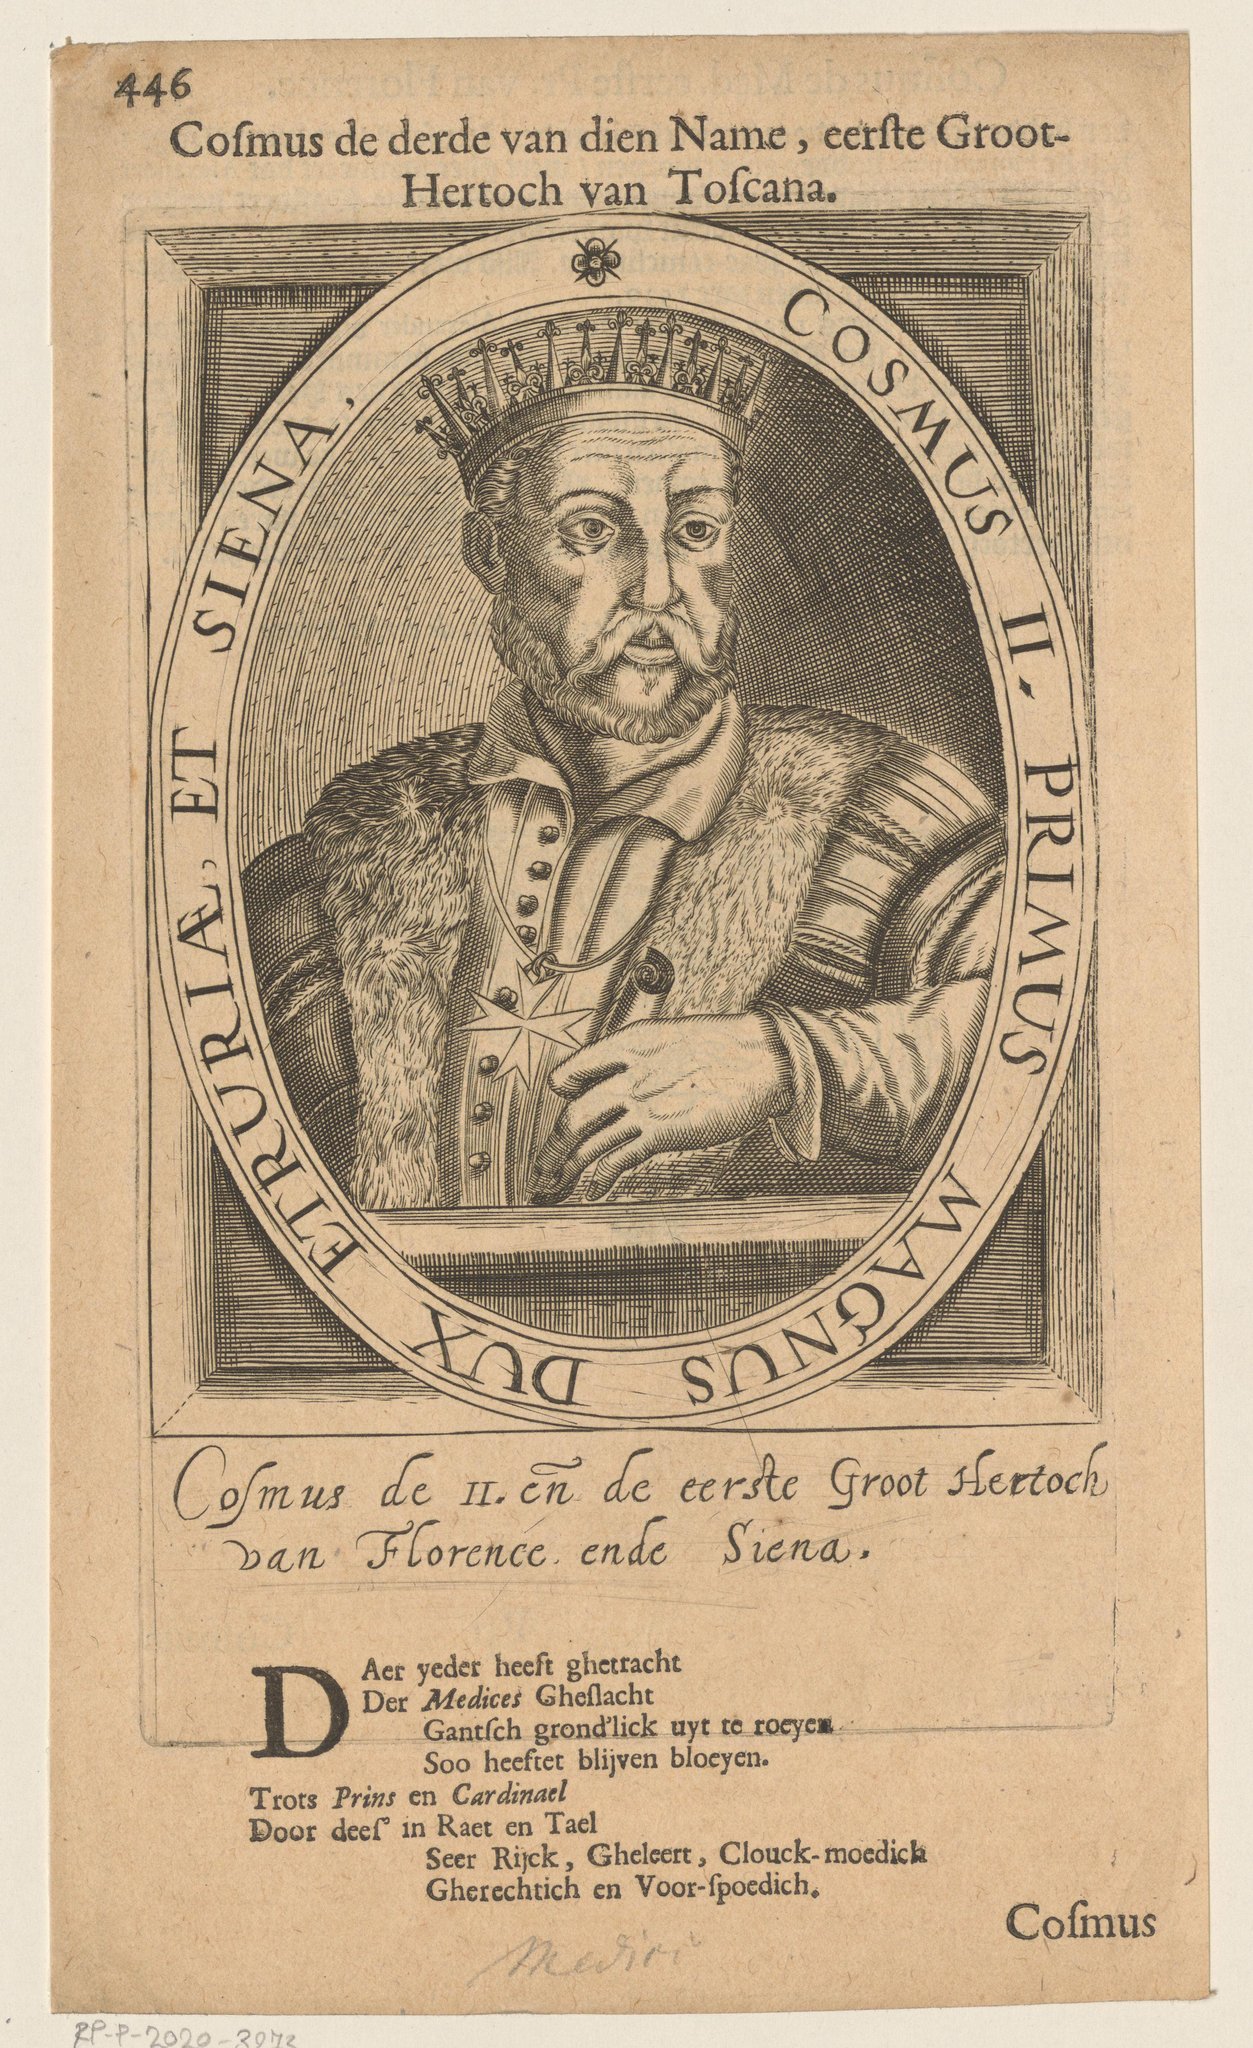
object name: book illustration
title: Portret van Cosimo I de'Medici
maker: Anonymous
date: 1600-1699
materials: paper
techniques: engraving, letterpress printing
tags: cosimo i de' medici, historical persons